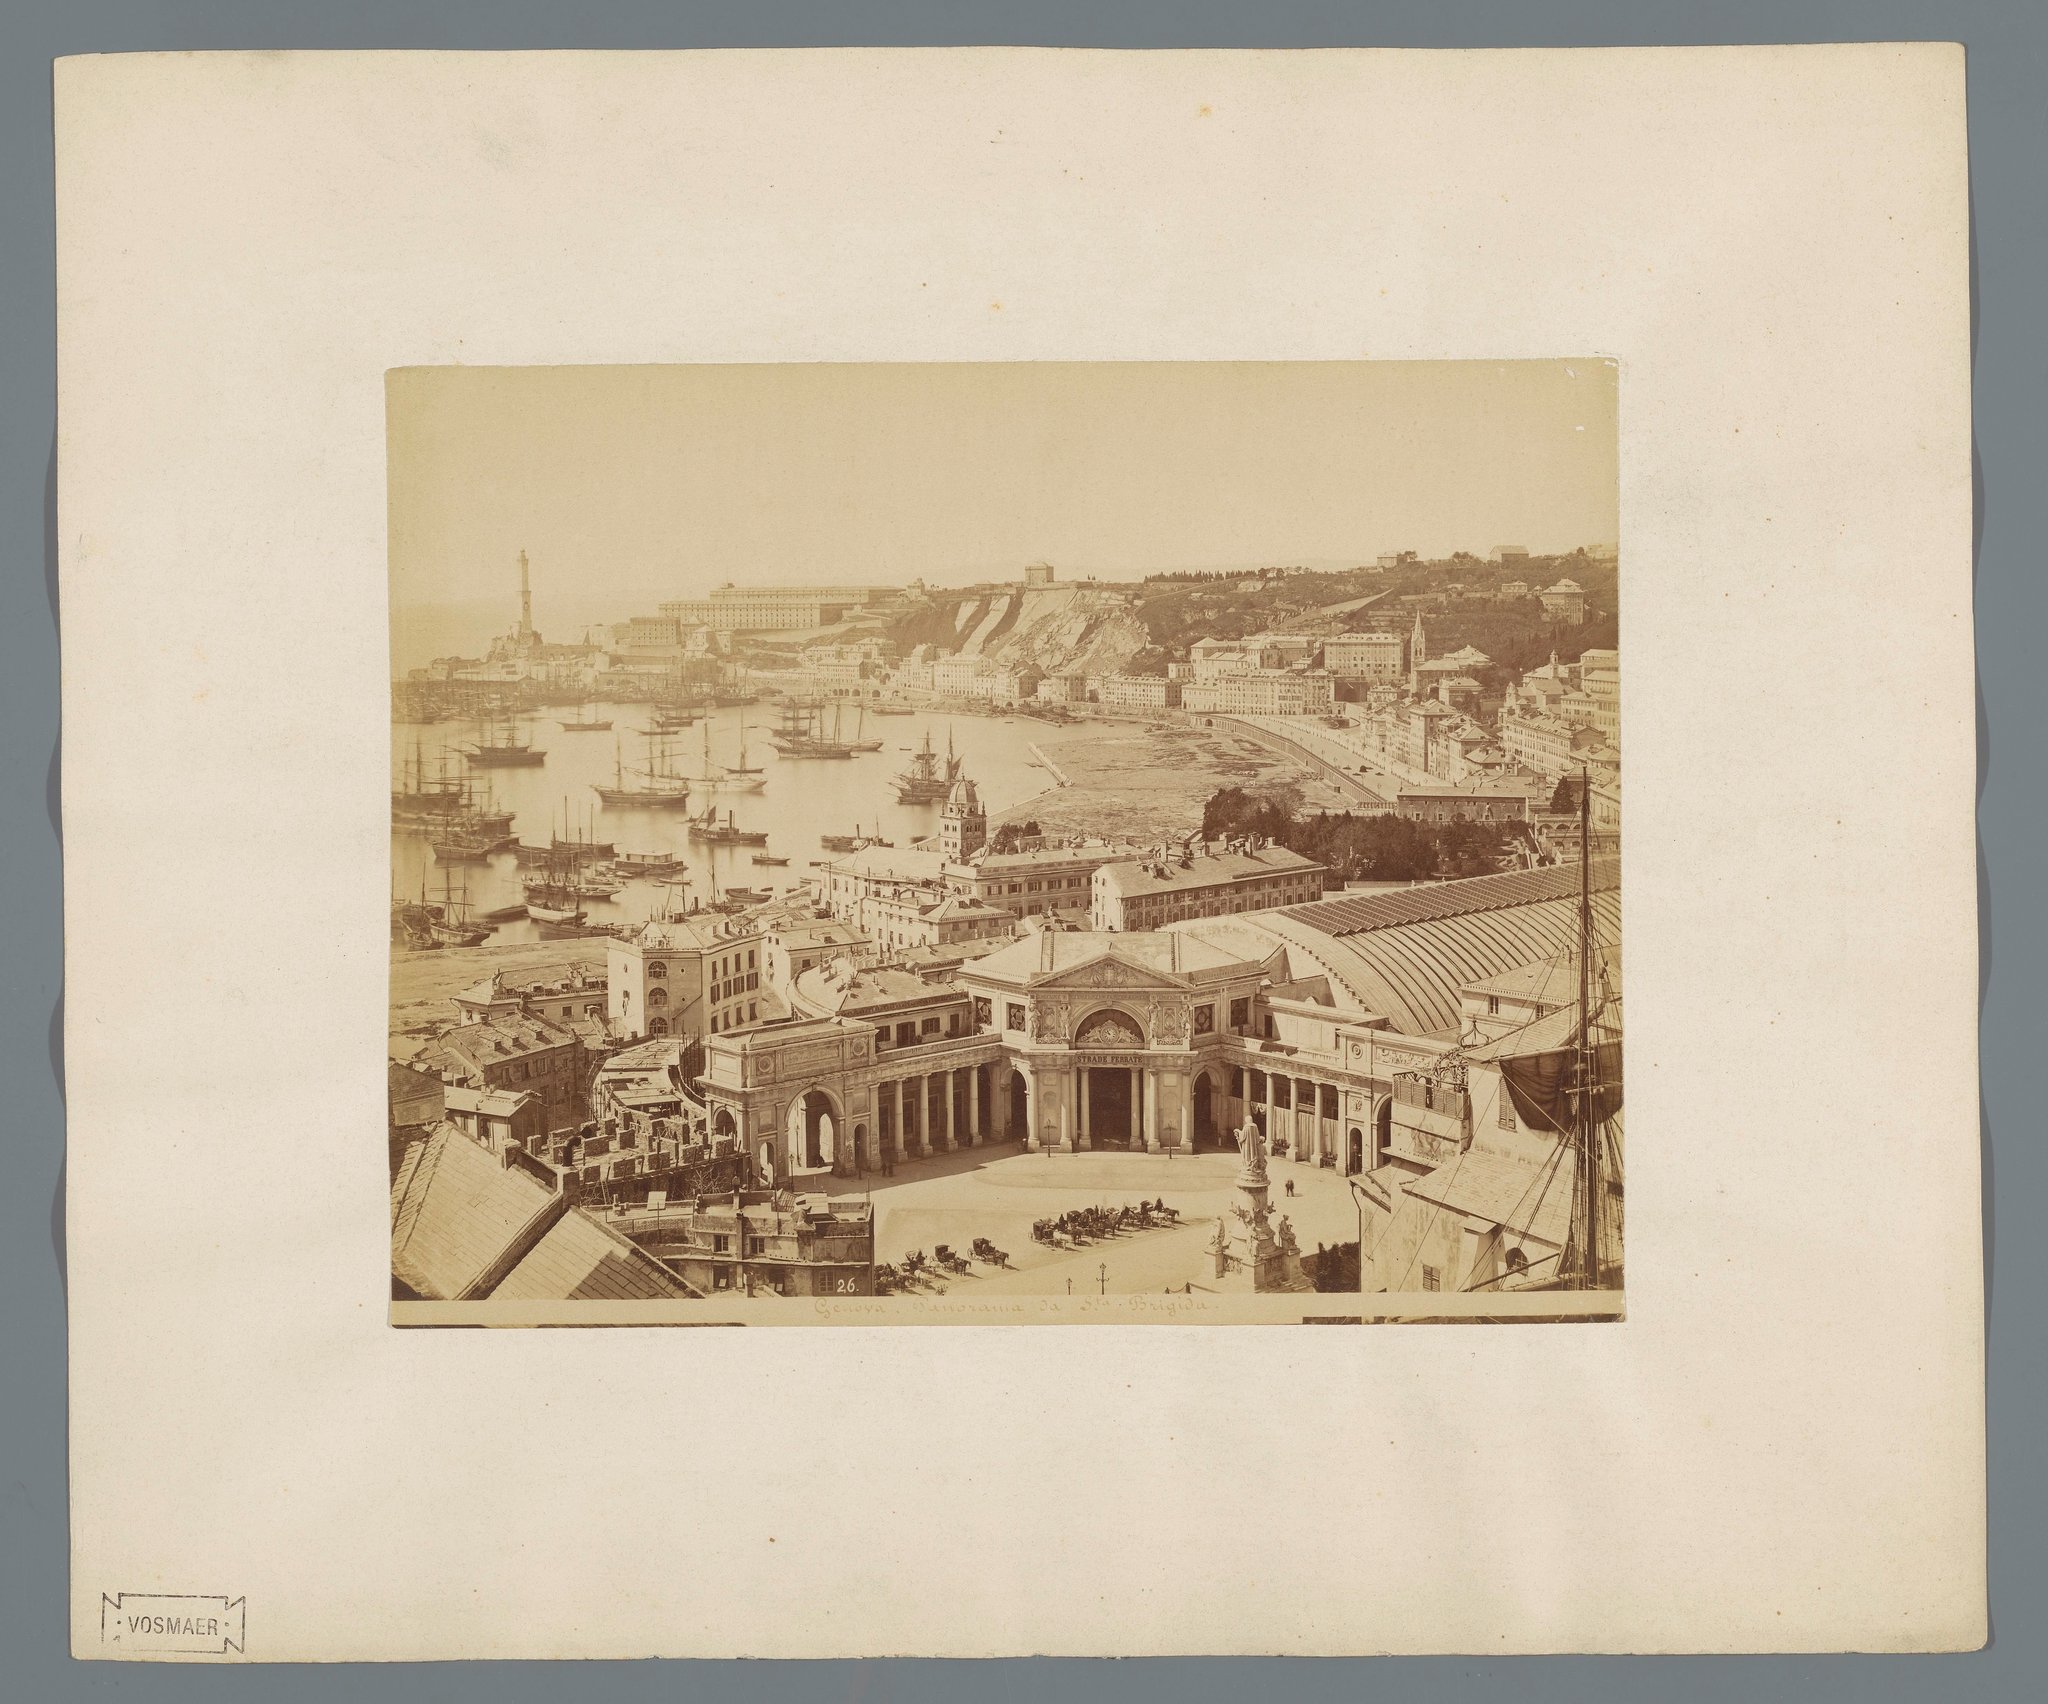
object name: photograph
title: Panorama da Sta Brigida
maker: Anonymous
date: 1851-1900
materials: cardboard, paper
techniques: albumen print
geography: genoa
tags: harbour, city-view in general; 'veduta', station; shelter (railway, tramway)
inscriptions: number: ‘26.’, collector's mark: ‘VOSMAER’